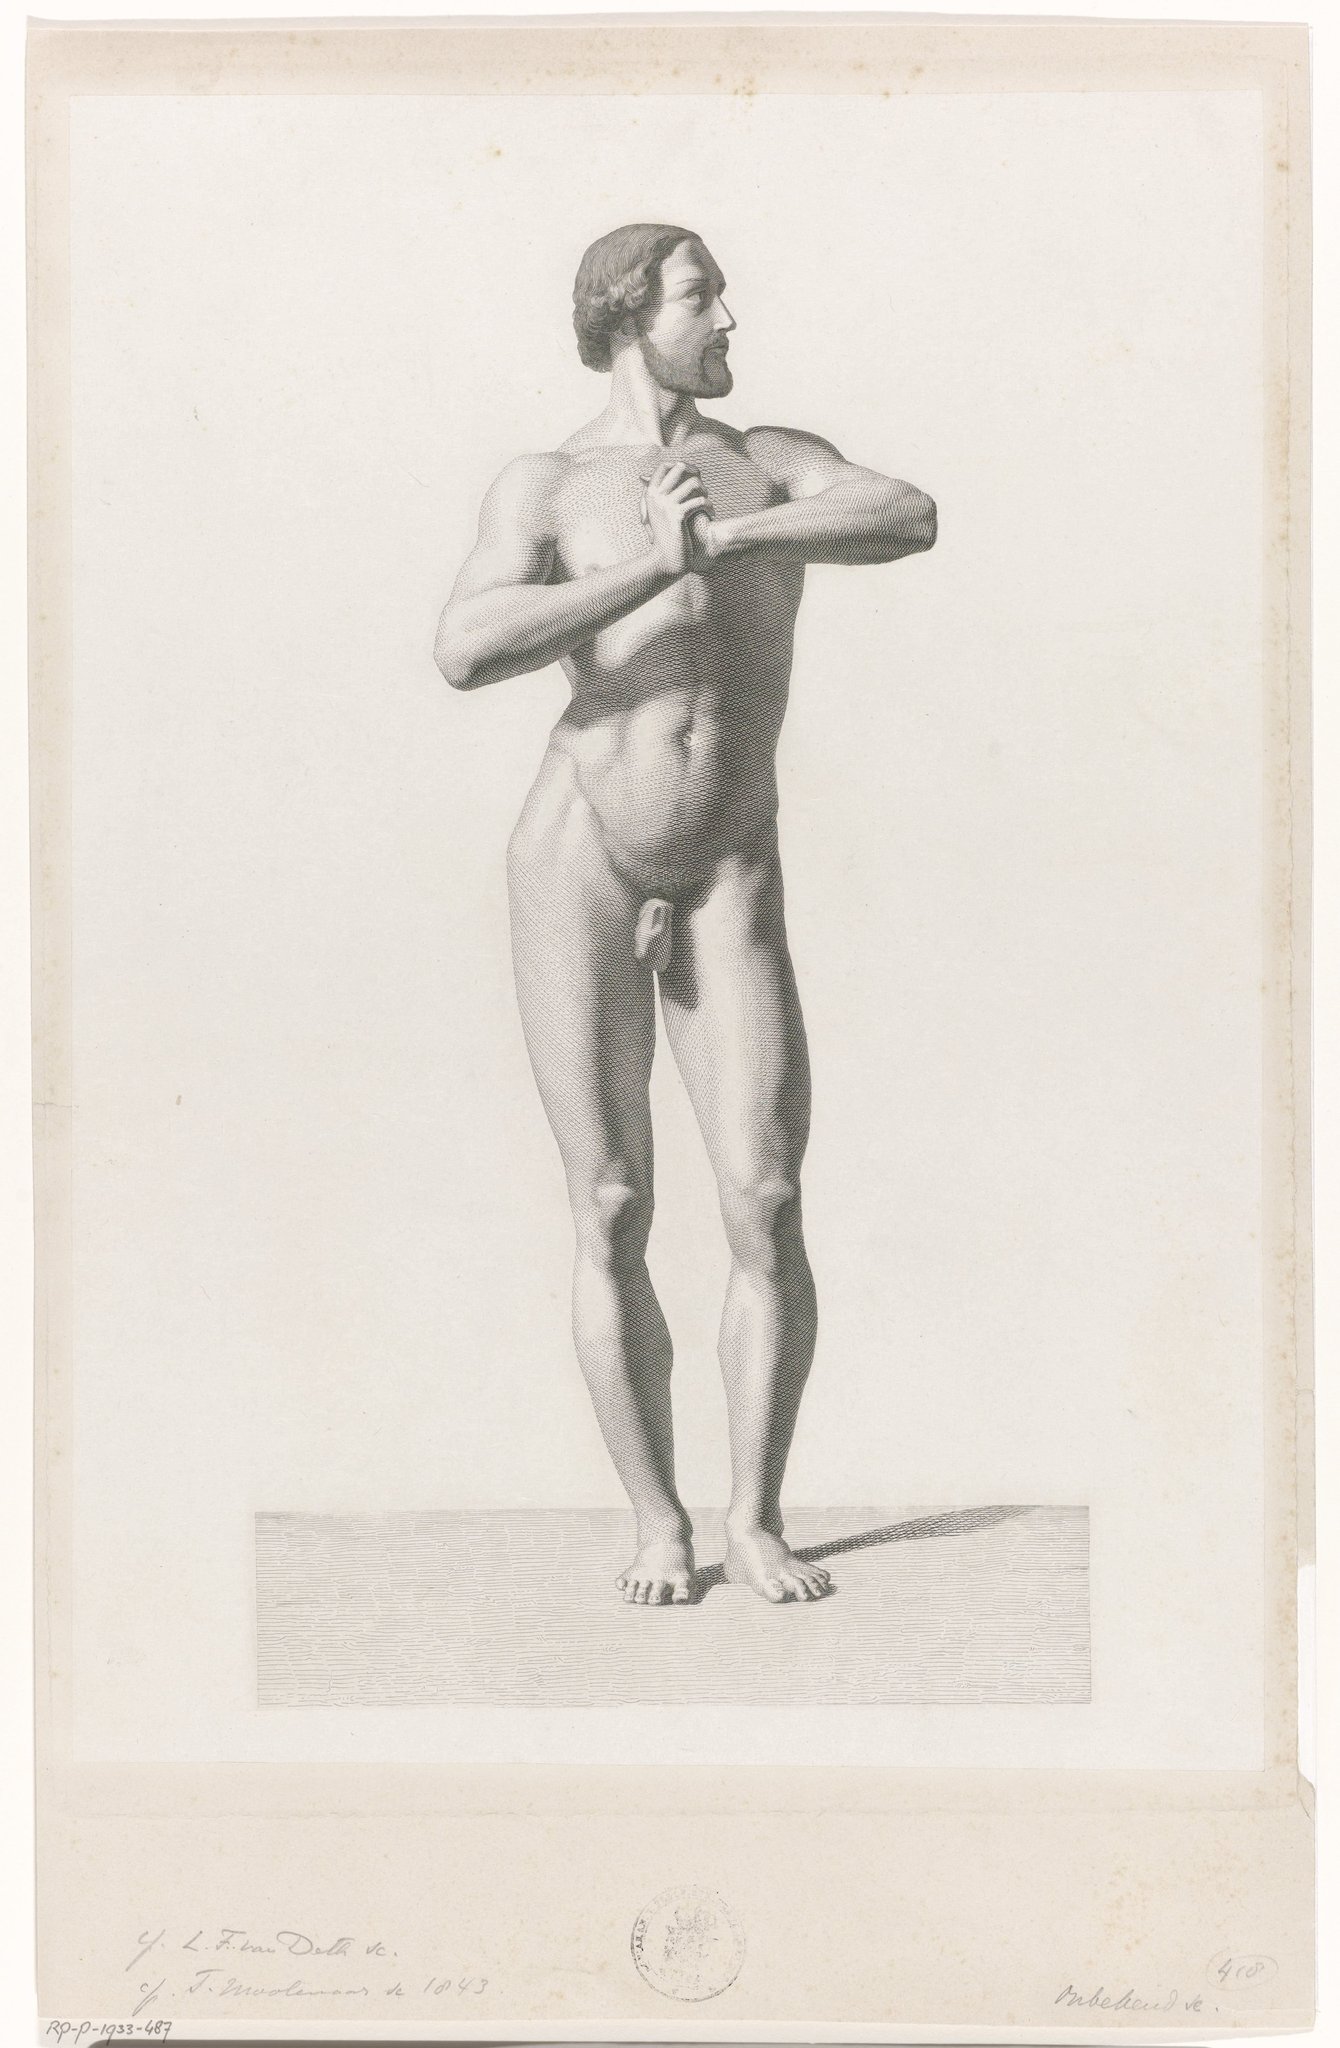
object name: print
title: Studie van een staande naakte man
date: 1843-1844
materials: paper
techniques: engraving, etching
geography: netherlands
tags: the (nude) human figure; 'corpo humano' (ripa)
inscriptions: collector's mark: Lugt 10, inscription: ‘Er staat onder aan het half vergane carton: / "aan den WelEd Hoogeb (sic!) Heer Apostool van zijnen gehoorzamen Dienaar.’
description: Deze prent is vervaardigd door een student van de Rijksakademie van beeldende kunsten. RP-P-OB-23.650 is een studie naar hetzelfde model.